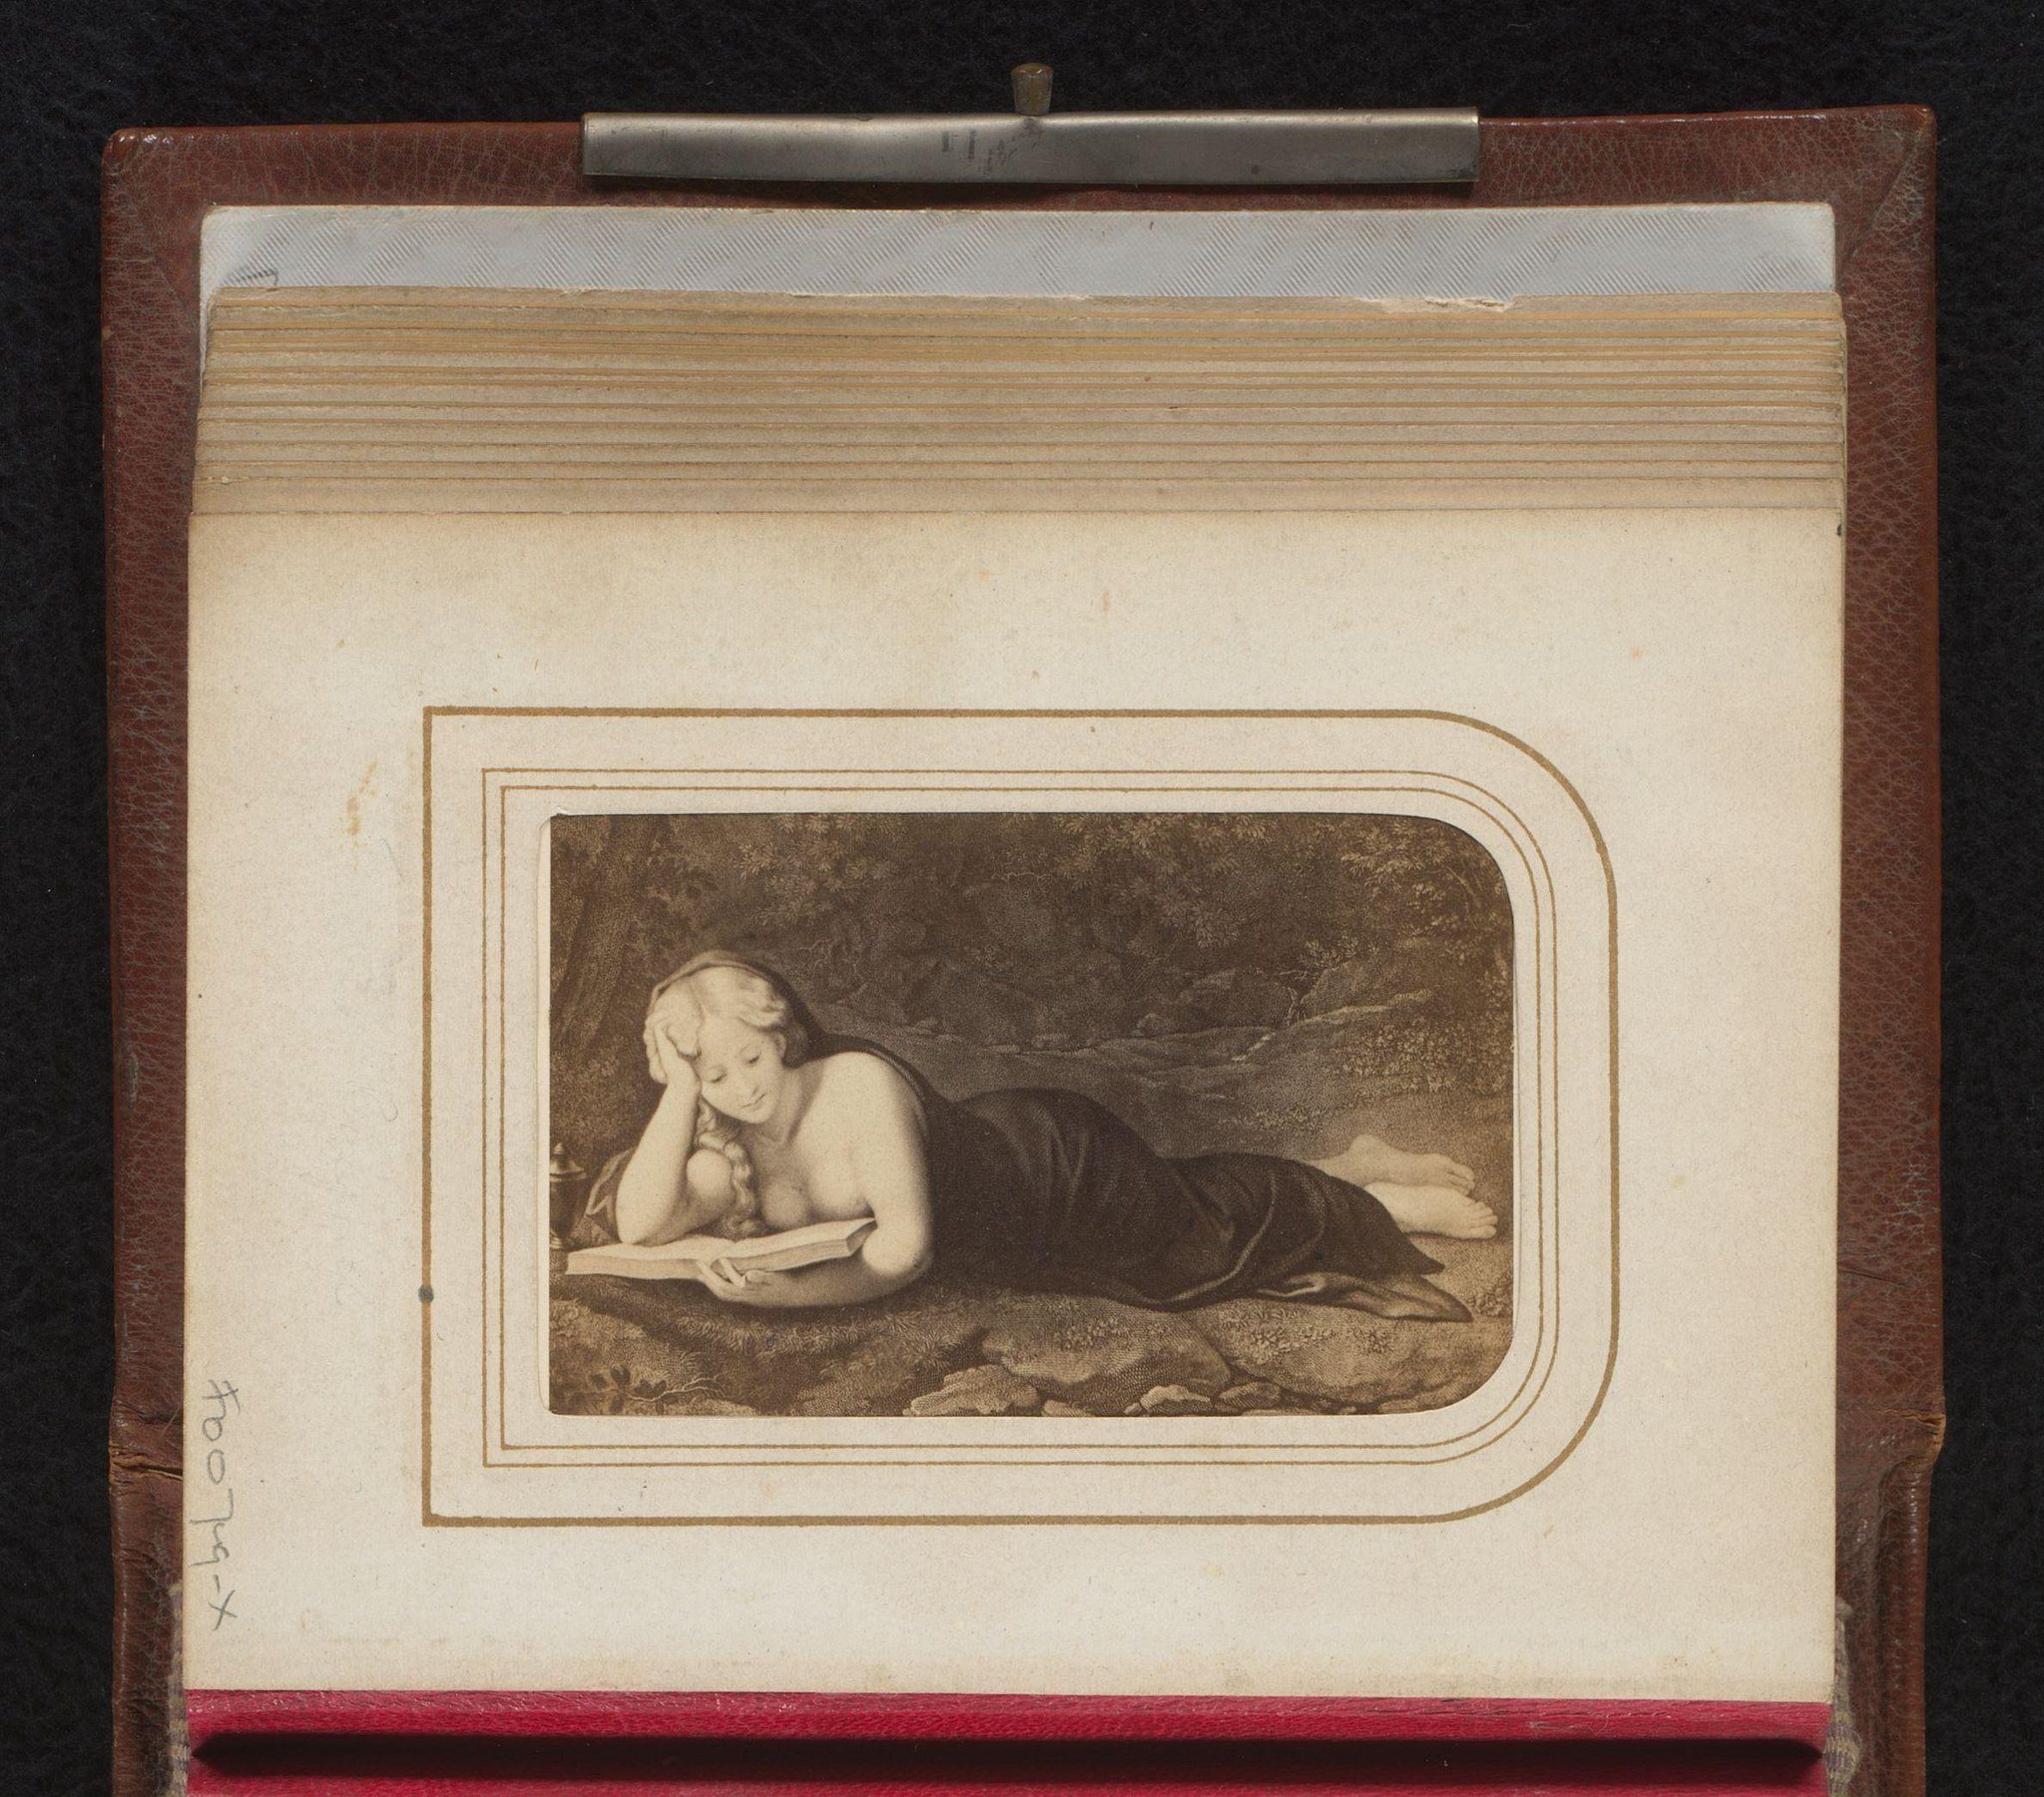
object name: carte de visite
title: Fotoreproductie van een prent met Maria lezend op de grond door Guiseppe Longhi naar Correggio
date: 1865-1900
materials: cardboard, photographic support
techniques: albumen print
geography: berlin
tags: the virgin mary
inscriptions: inscription: ‘Correggio: /Die heilige Magdalene. (D.G.)/ 27./ Sainte Madeleine. Saint Magdalen./ Gustav Schauer/ Photographisches Kunst- und Verlags - Institut/ Berlin/ Grosse Friedrichs - Strasse 188’